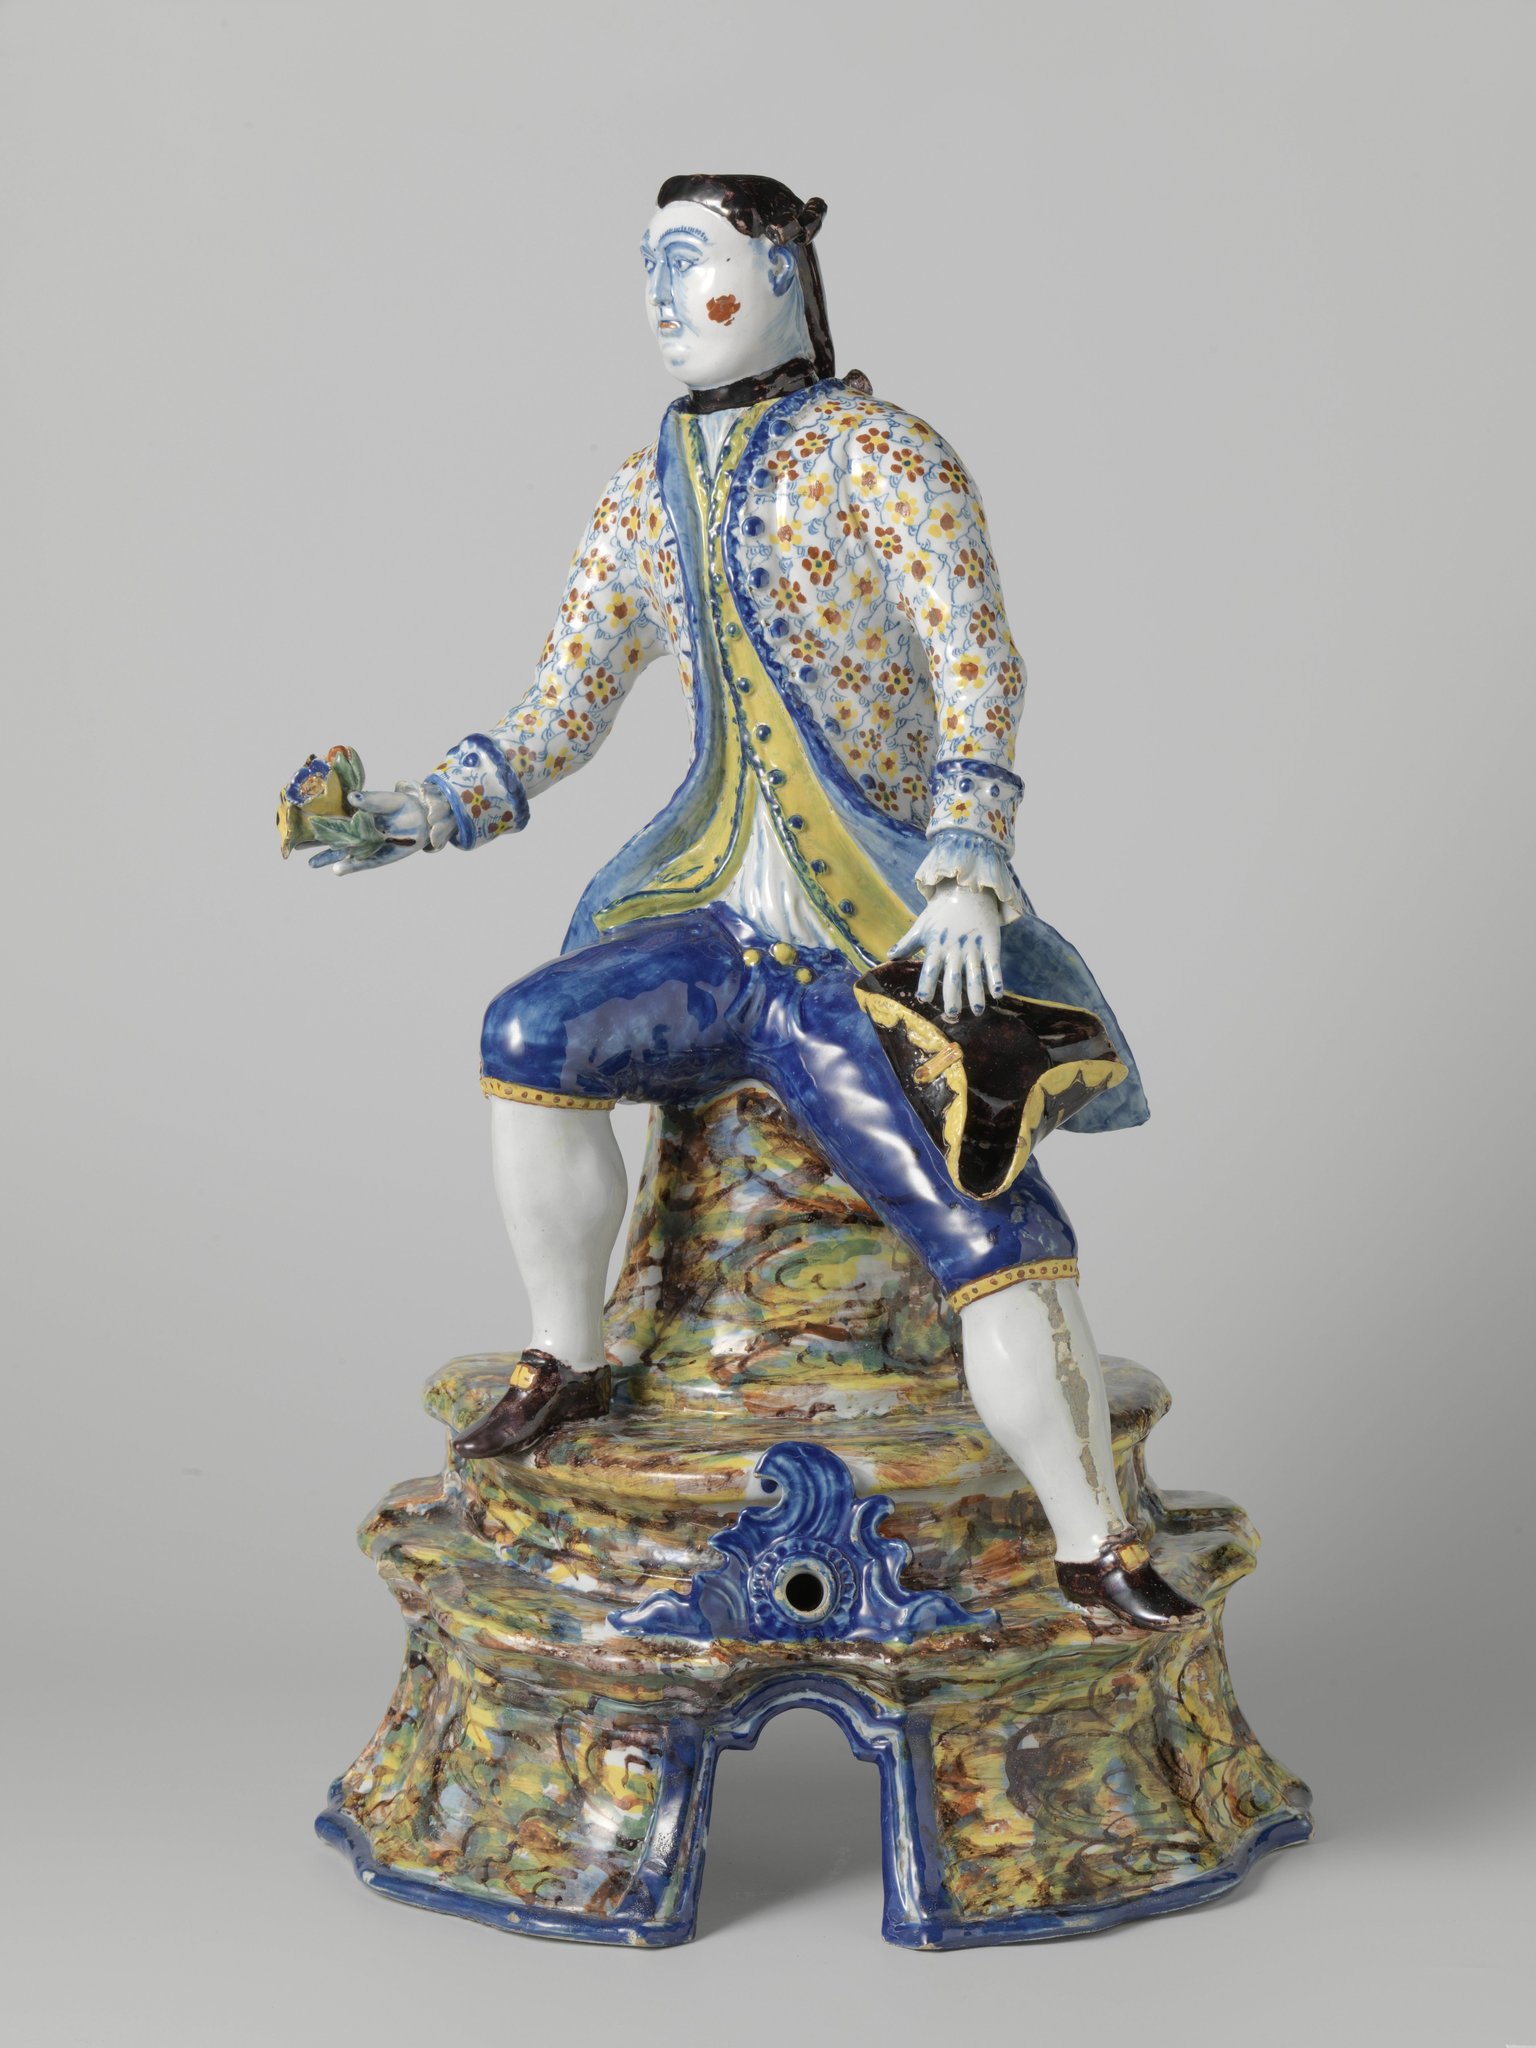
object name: fountain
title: Fontein in de vorm van een zittende man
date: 1760-1775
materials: earthenware, glaze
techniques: painted, polychromy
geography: delft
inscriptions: collector's mark: ‘collection JF Loudon’, mark: ‘figuratief teken klauw’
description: Fontein van veelkleurig beschilderde faïence. De fontein heeft de vorm van een man, zittend op een geprofileerd voetstuk.